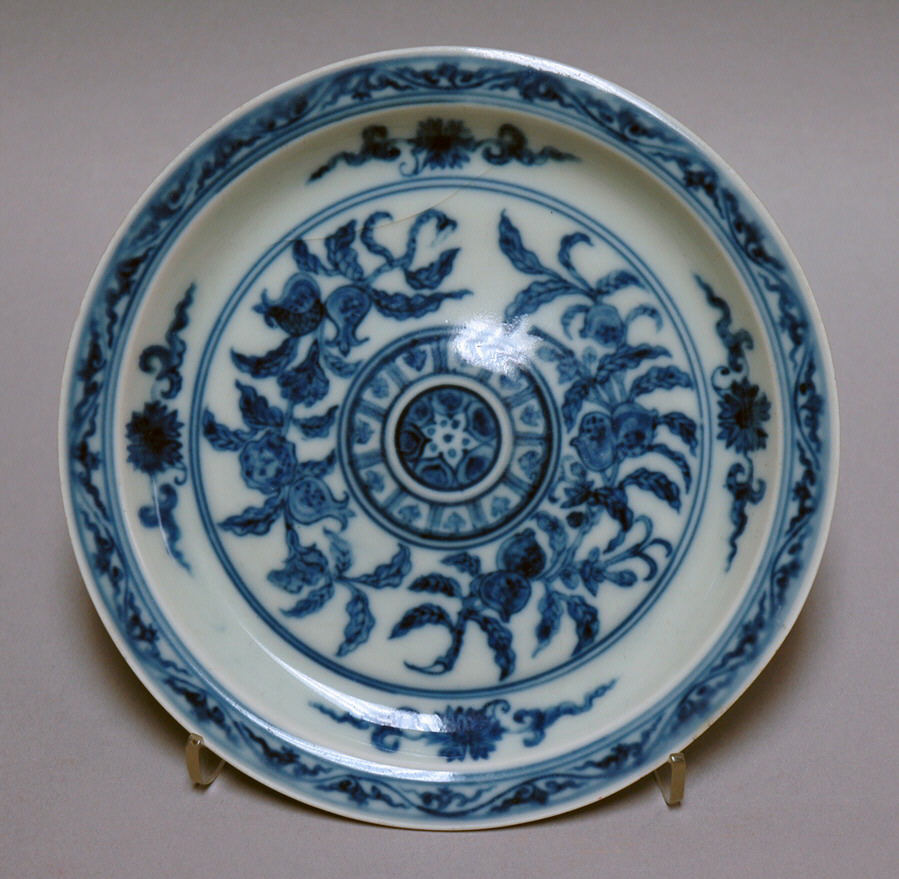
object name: saucer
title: Saucer with pomegranates and peaches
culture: chinese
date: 1401-1500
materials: cobalt, porcelain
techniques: painting, underglaze